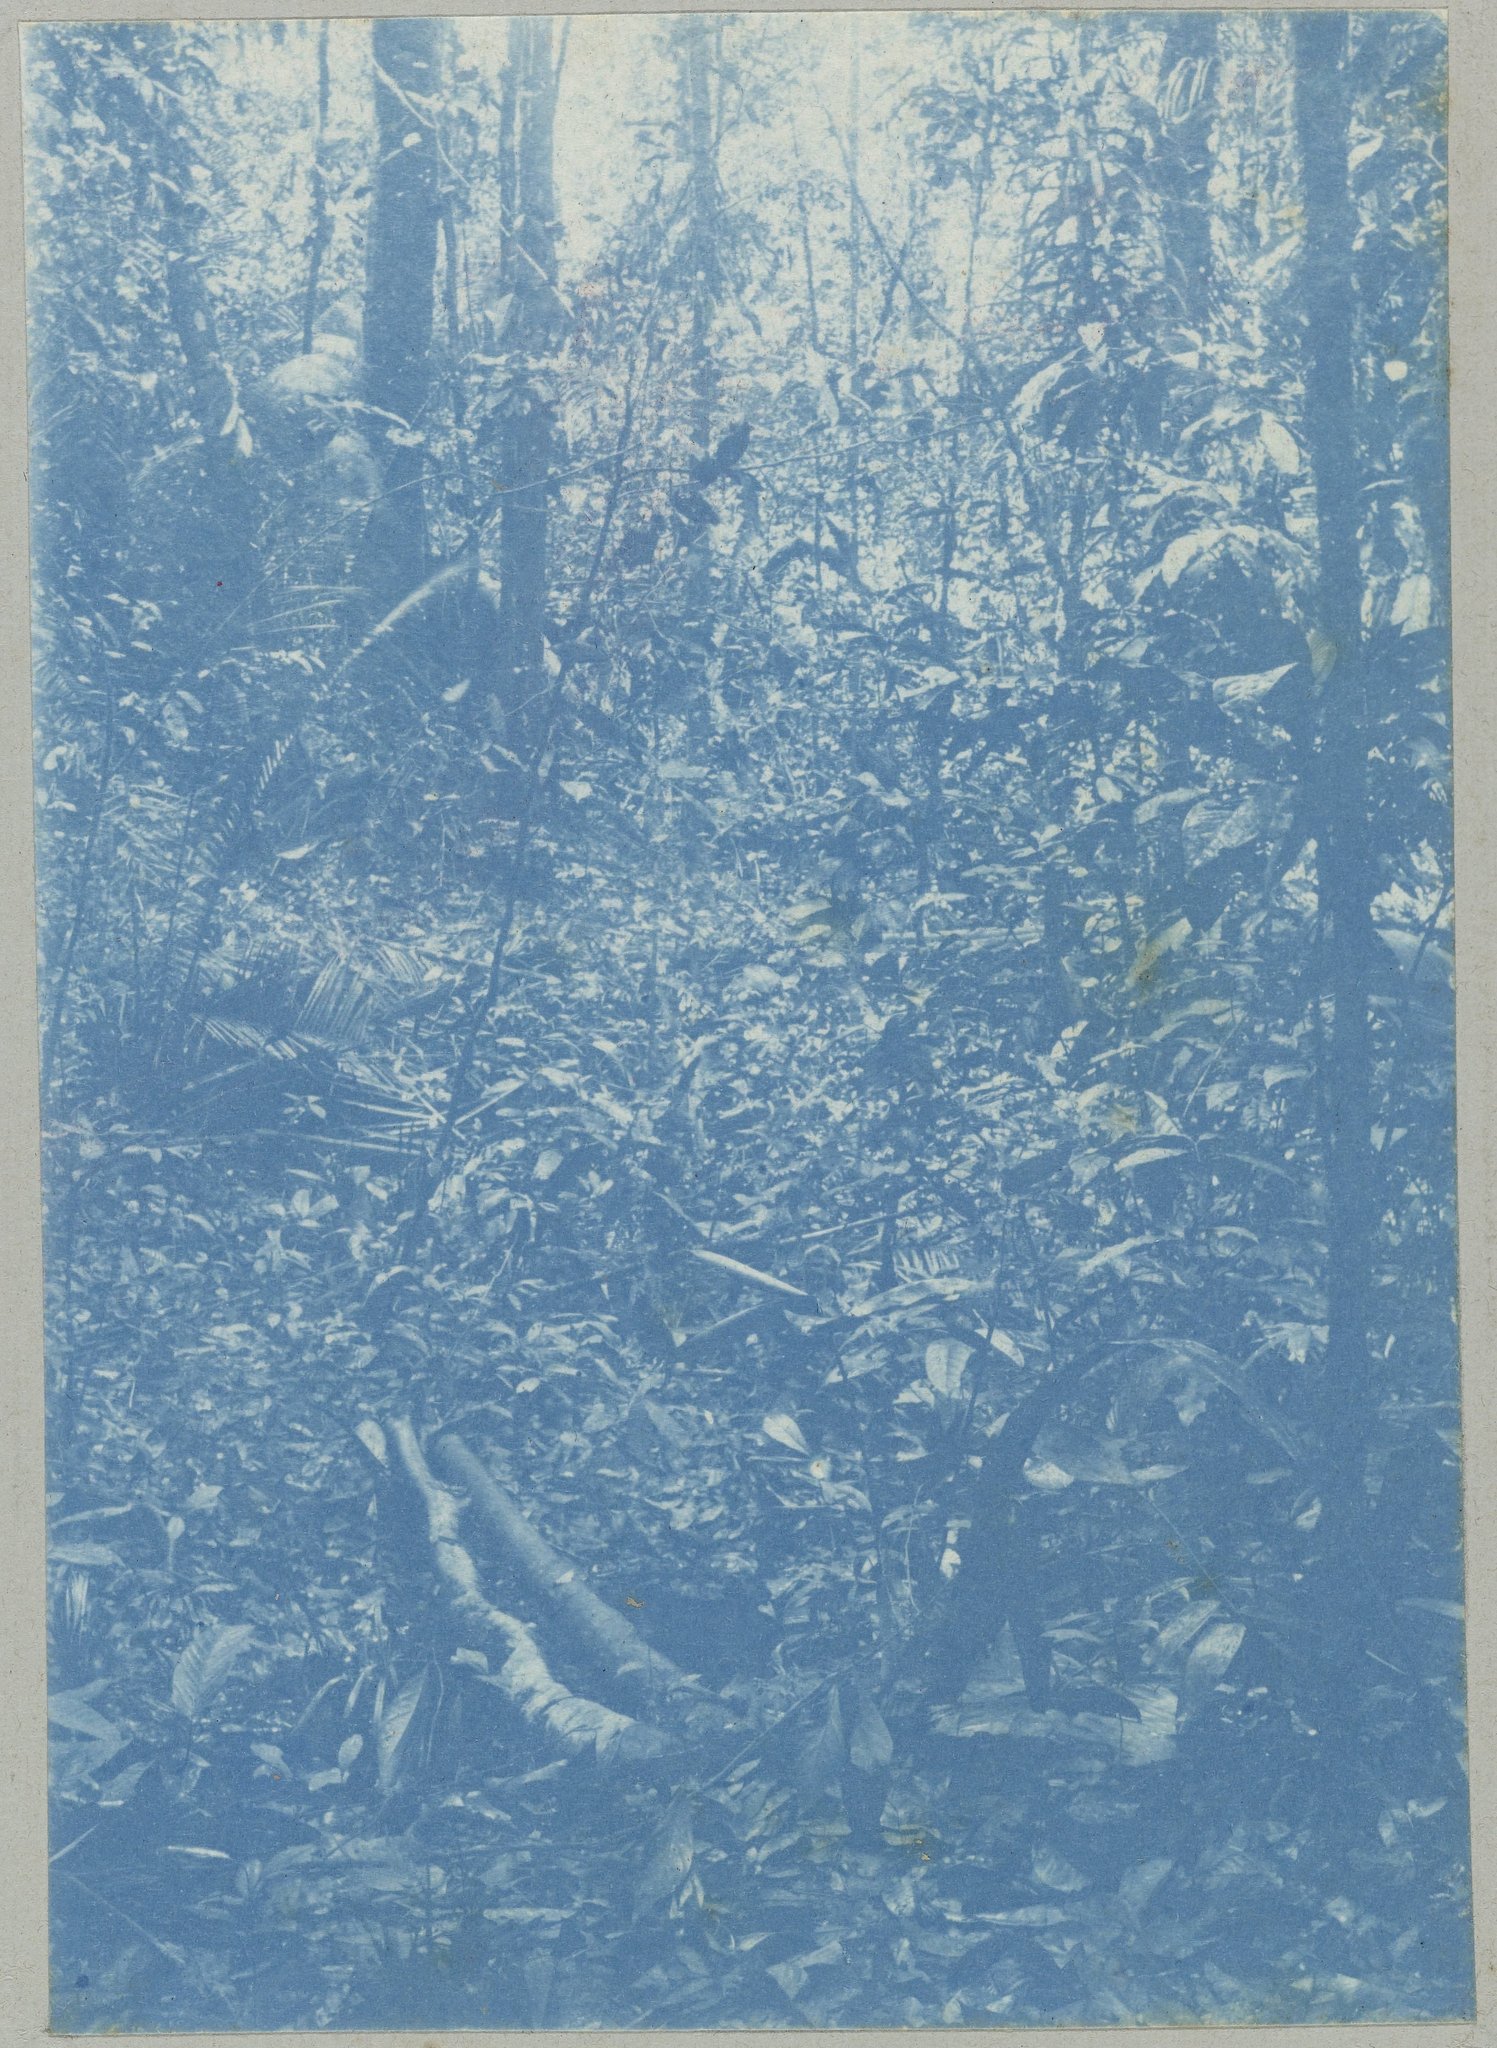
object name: photograph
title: Oerwoud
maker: hendrik doijer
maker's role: engineer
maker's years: 1863-1925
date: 1903-1910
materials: photographic support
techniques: cyanotype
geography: suriname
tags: suriname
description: Gezicht in het oerwoud. Onderdeel van het fotoalbum Souvenir de Voyage (deel 1), over het leven van de familie Doijer in en rond de plantage Ma Retraite in Suriname in de jaren 1903-1910.